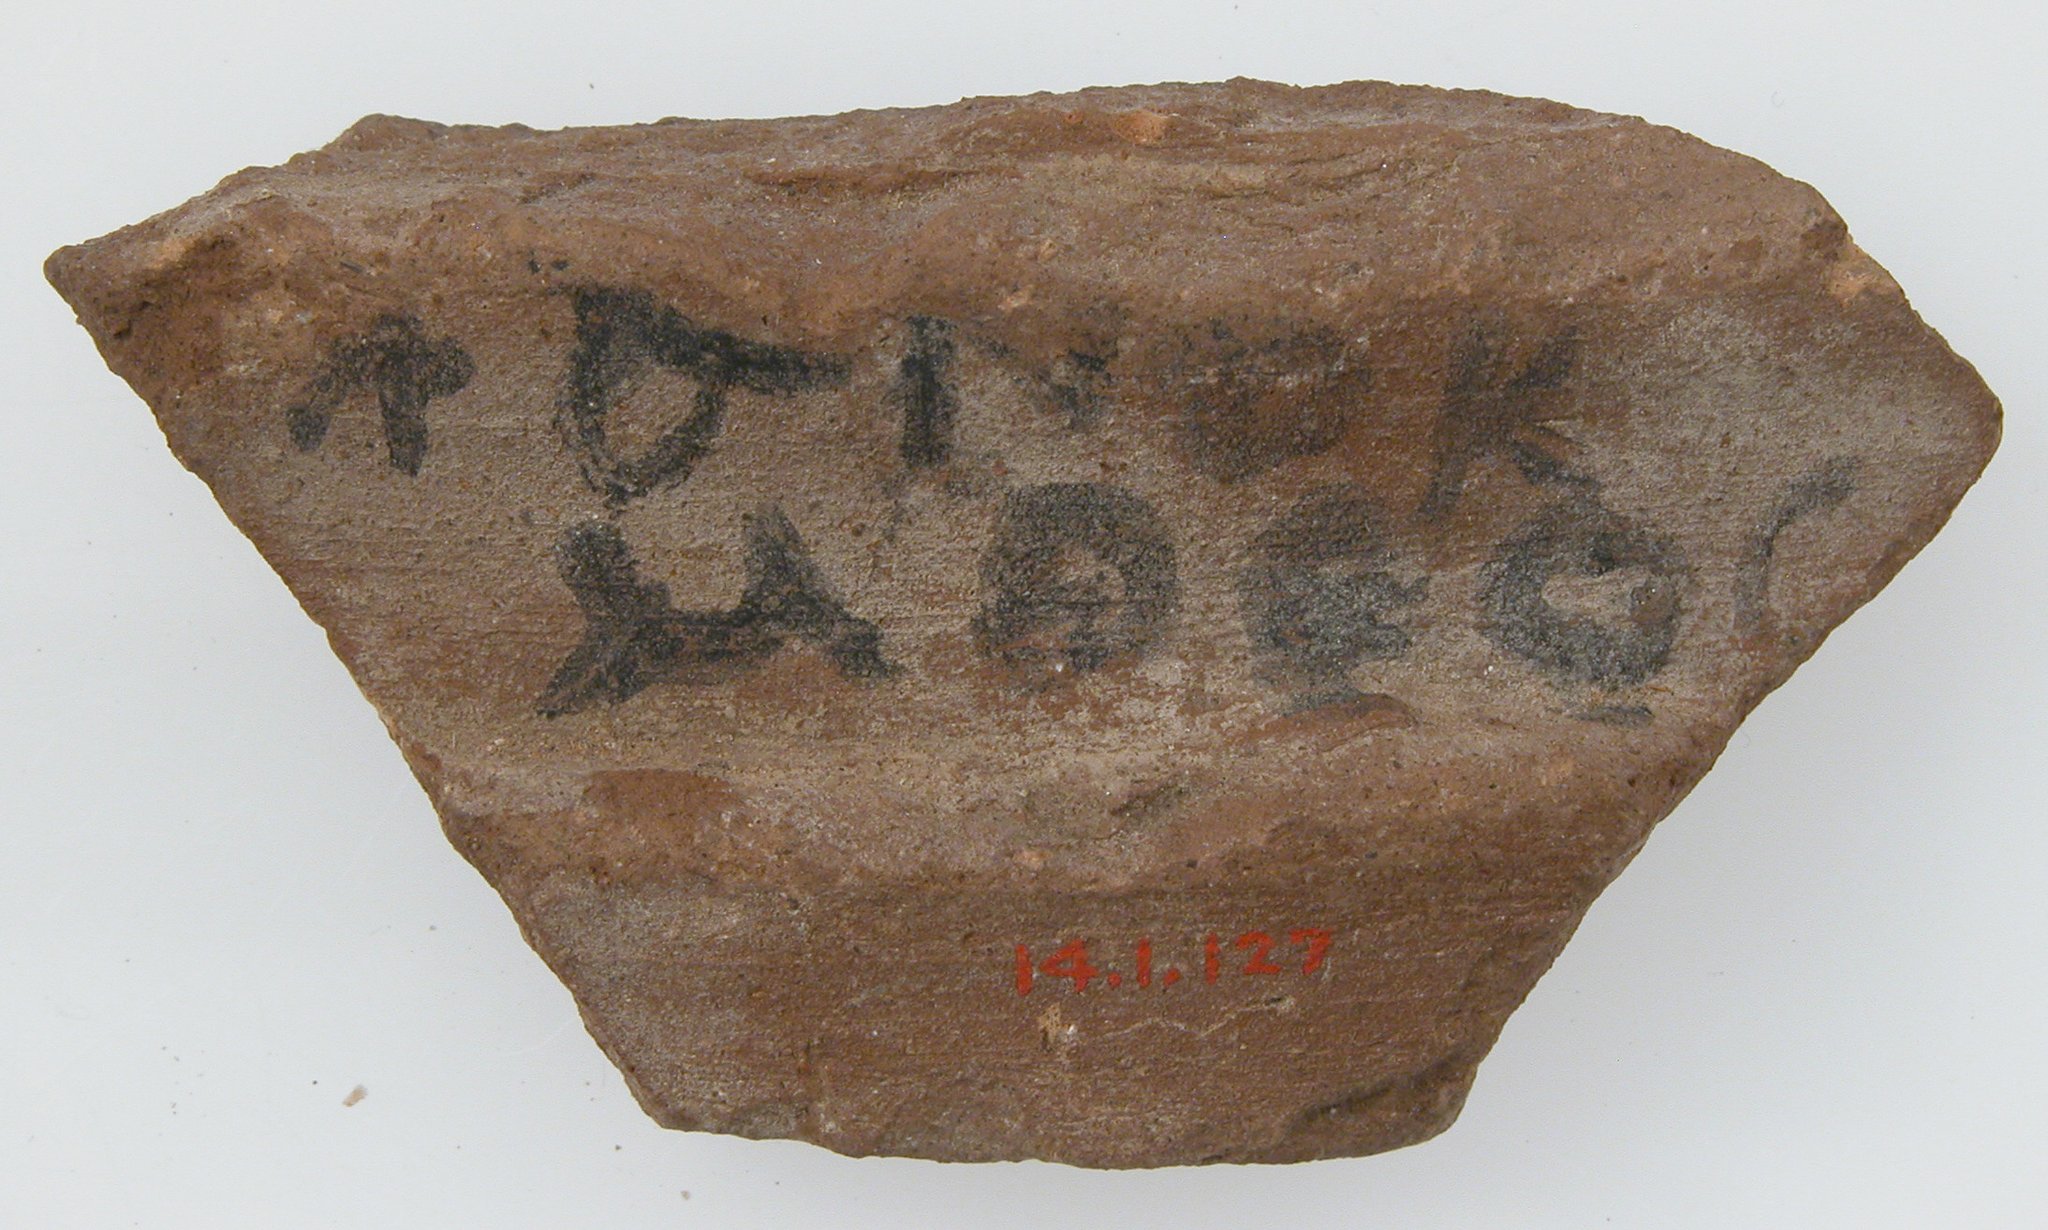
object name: ostrakon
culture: coptic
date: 600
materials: ink, pottery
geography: egypt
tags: coptic,documents